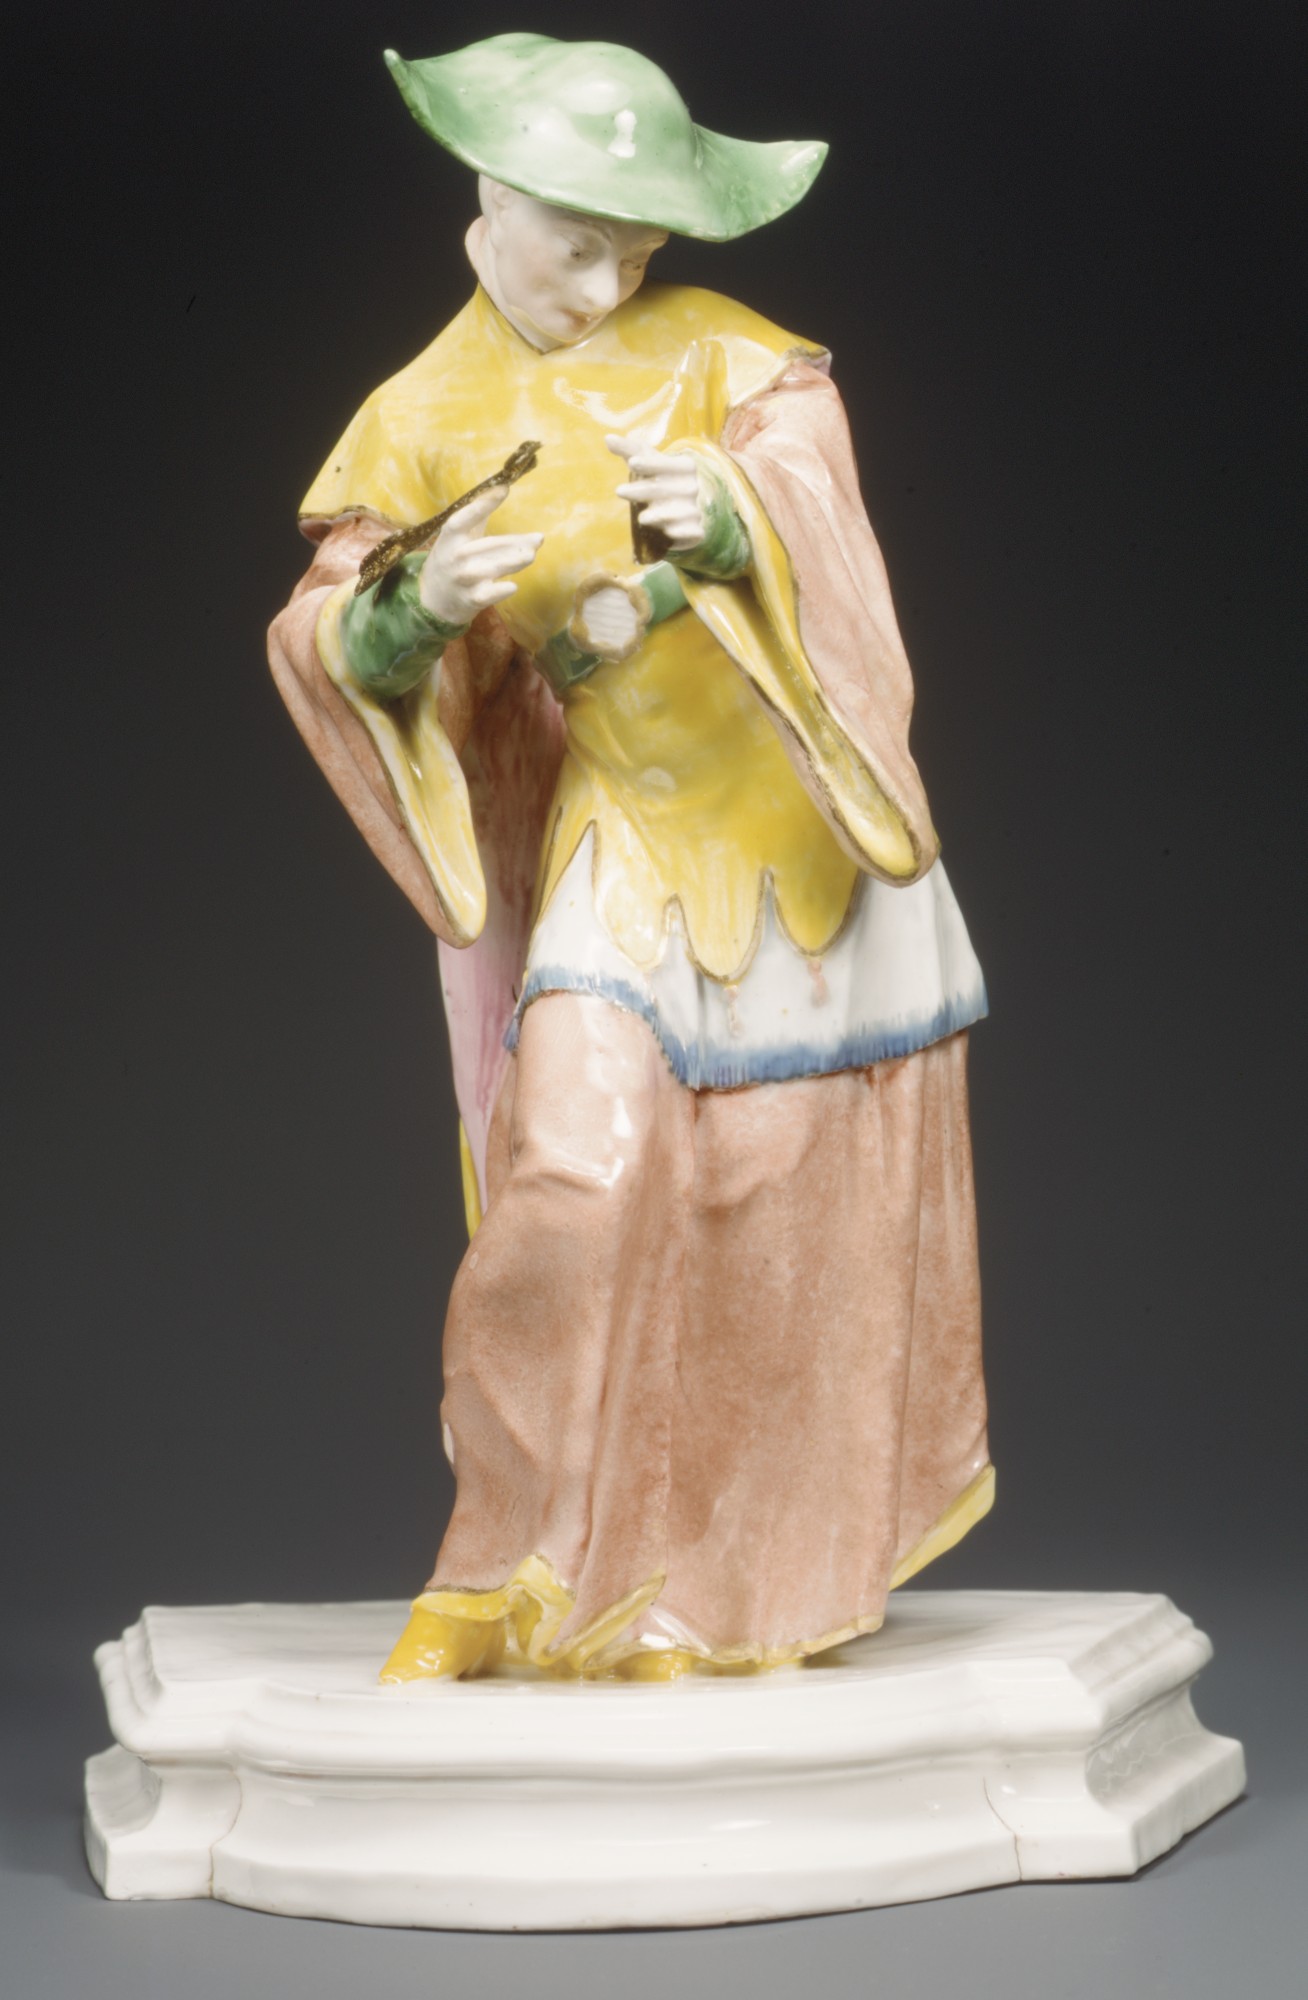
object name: figure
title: Chinese man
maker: nymphenburg porcelain manufactory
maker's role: manufactory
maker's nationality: german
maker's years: 1747-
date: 1770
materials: hard paste porcelain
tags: men